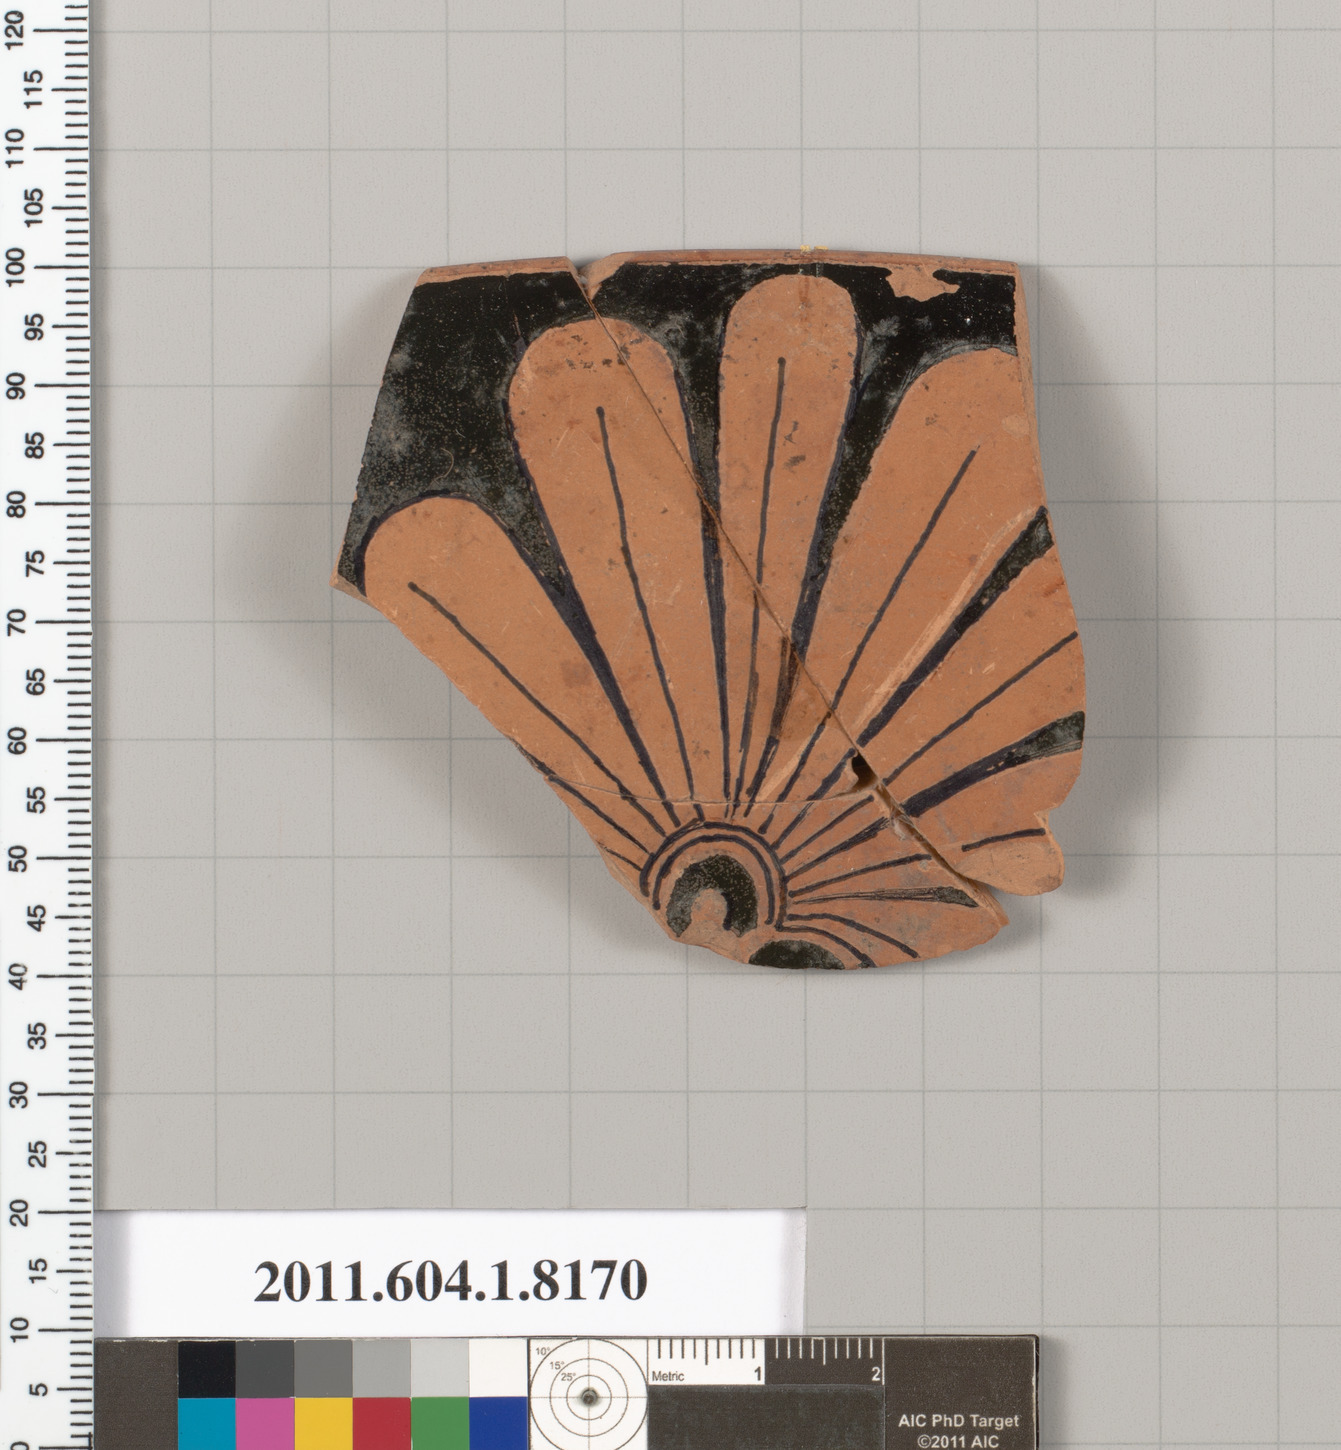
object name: kylix fragment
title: Terracotta rim fragment of a kylix (drinking cup)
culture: greek, attic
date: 520-510 BCE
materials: terracotta